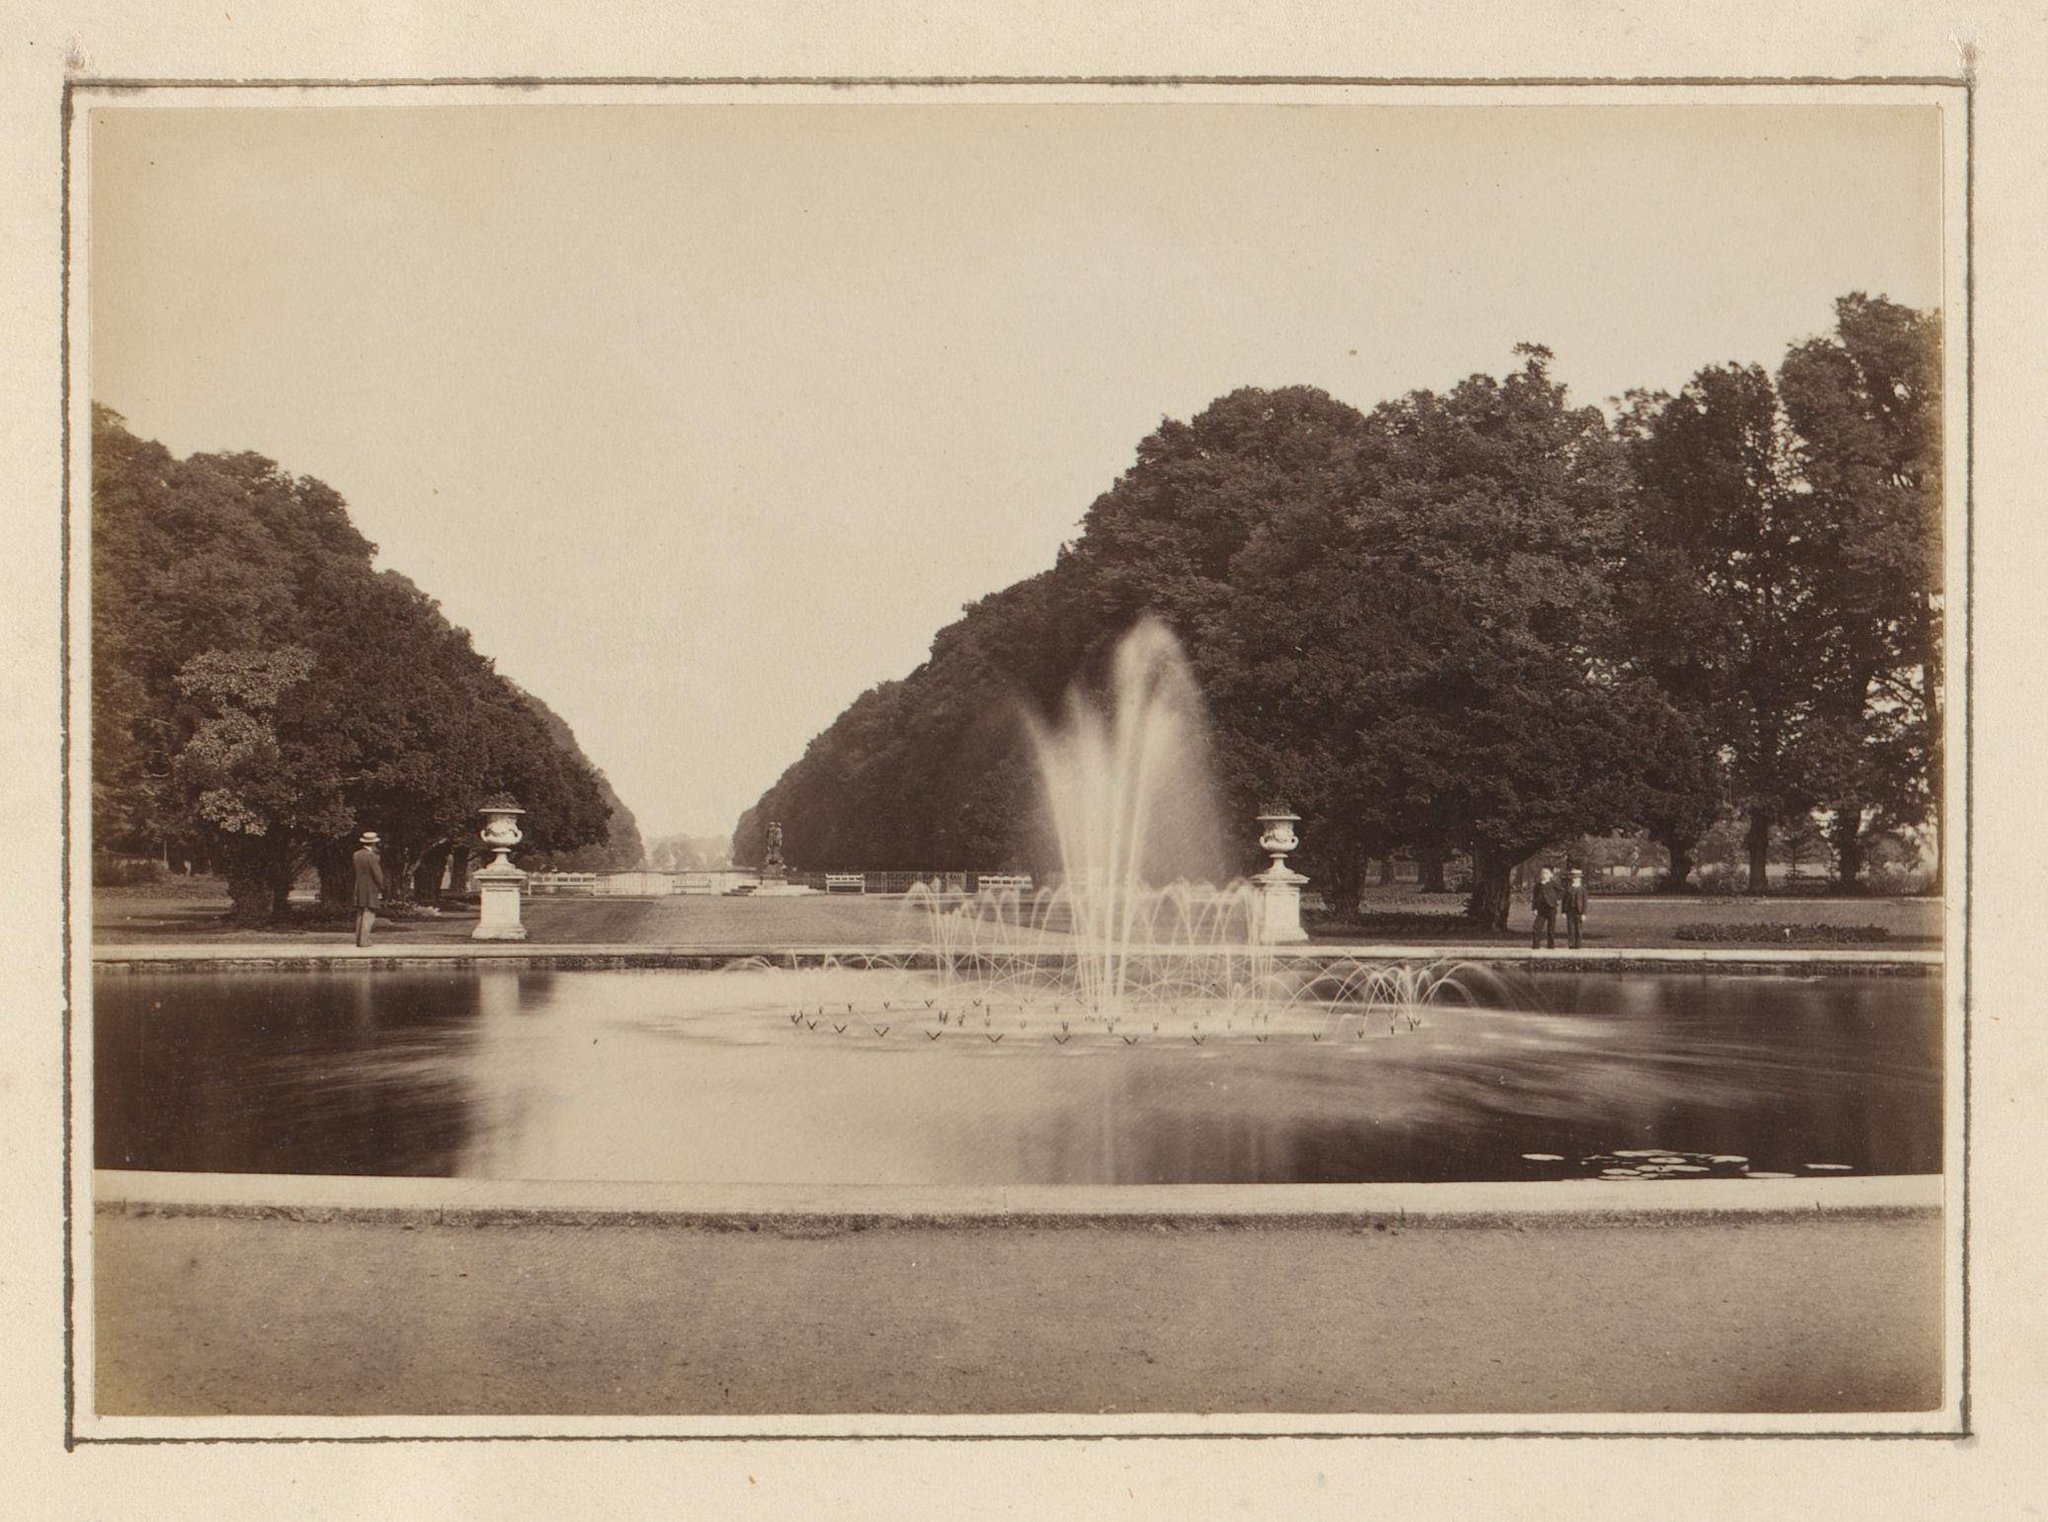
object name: photograph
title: Vijver bij Hampton Court Palace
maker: Anonymous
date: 1870-1890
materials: paper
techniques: albumen print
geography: hampton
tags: garden fountain, french or architectonic garden; formal garden